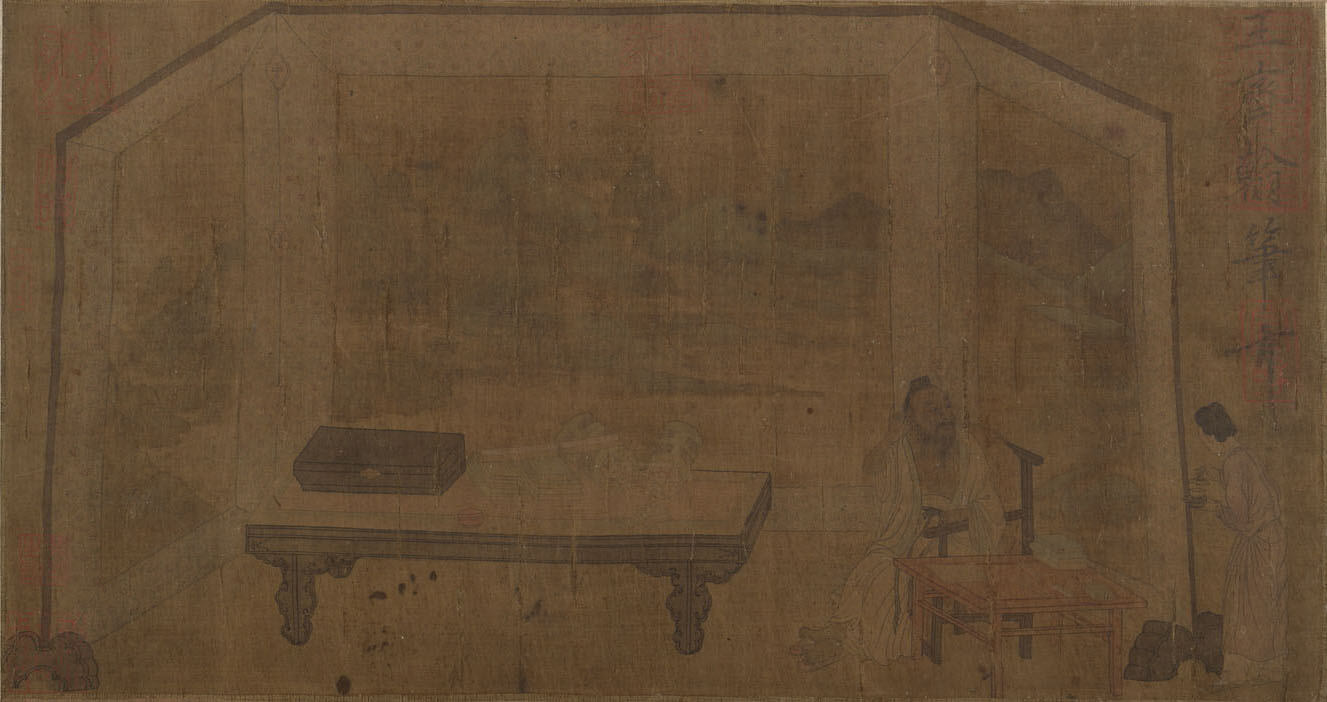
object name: handscroll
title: Library Scene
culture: chinese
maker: unidentified artist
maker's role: artist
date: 901-1000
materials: ink, silk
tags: books,libraries,interiors,men,women,tables